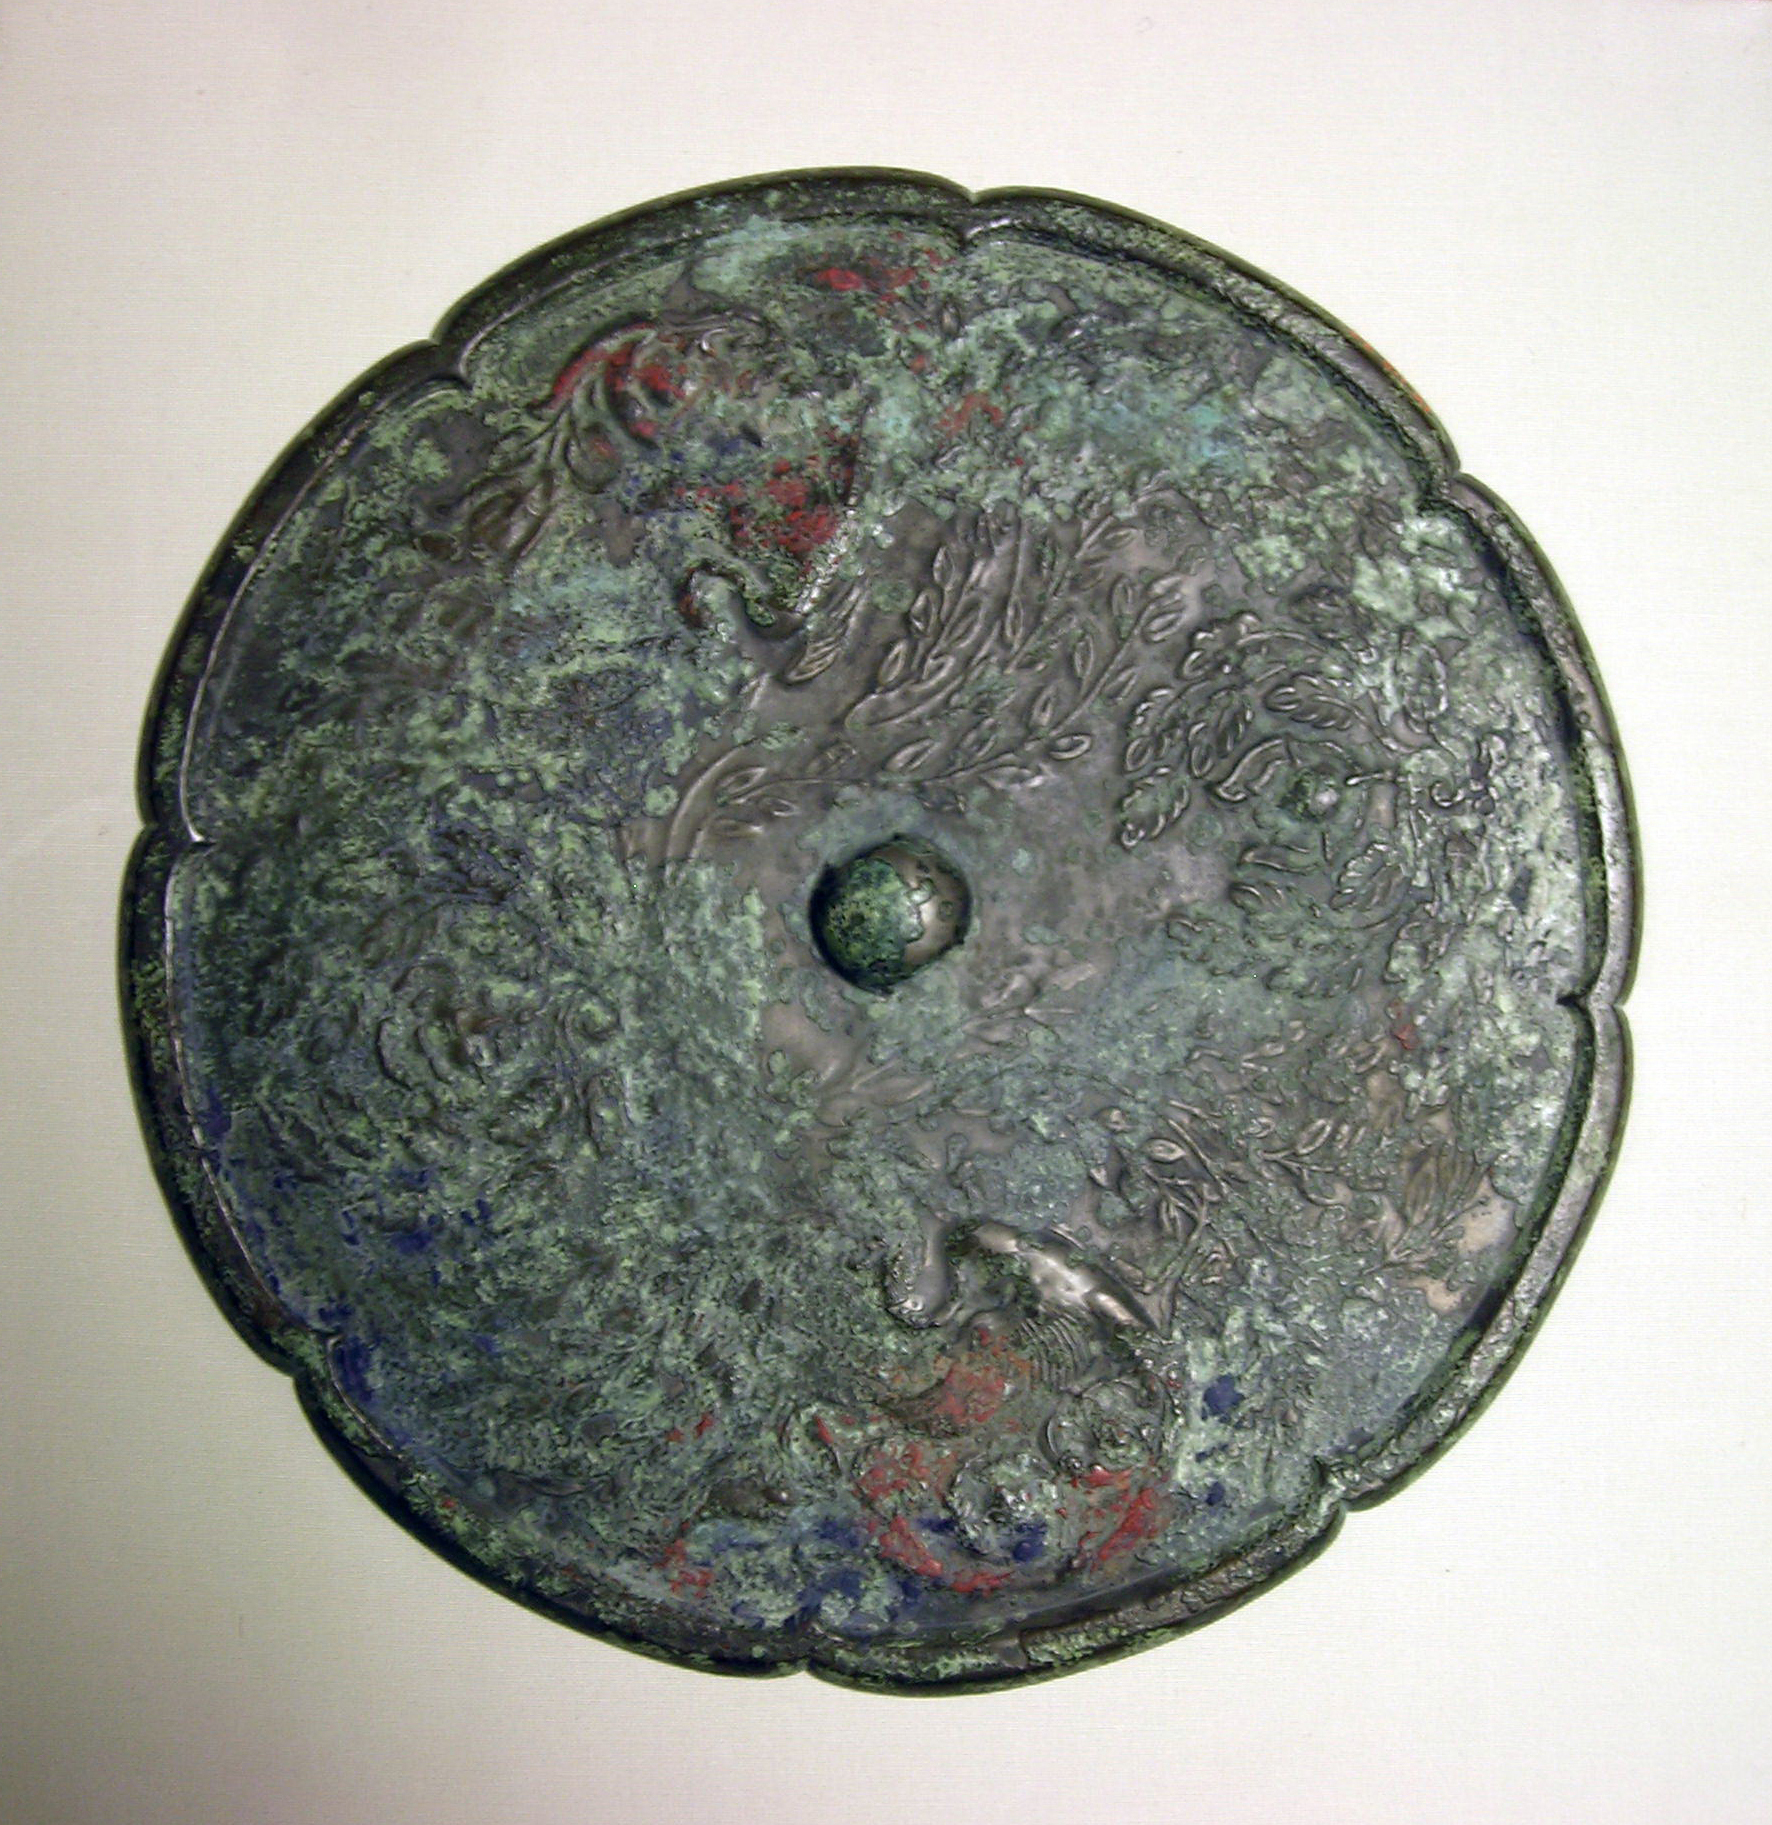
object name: mirror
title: Mirror with paired birds and floral designs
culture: chinese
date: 701-800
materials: bronze